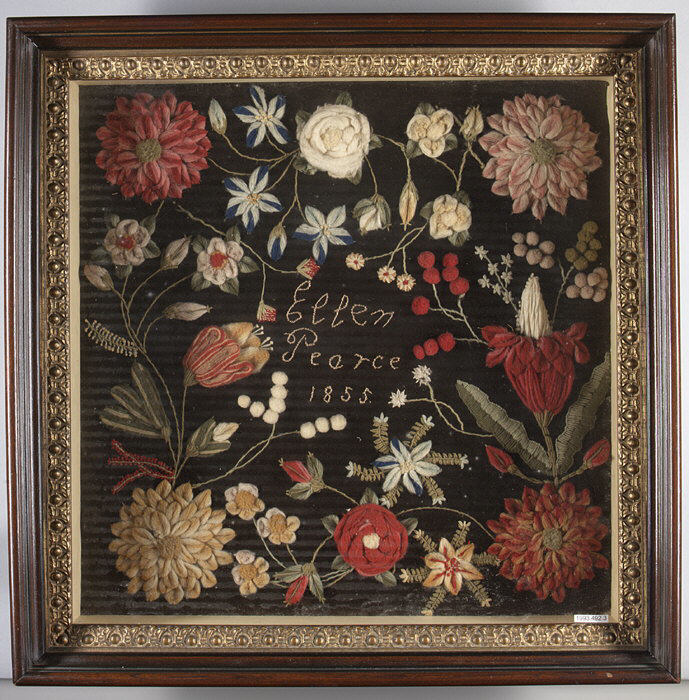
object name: embroidered picture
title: Picture or pillow face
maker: ellen pearce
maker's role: designer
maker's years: 1800-1900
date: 1855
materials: silk, wood, wool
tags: flowers,roses